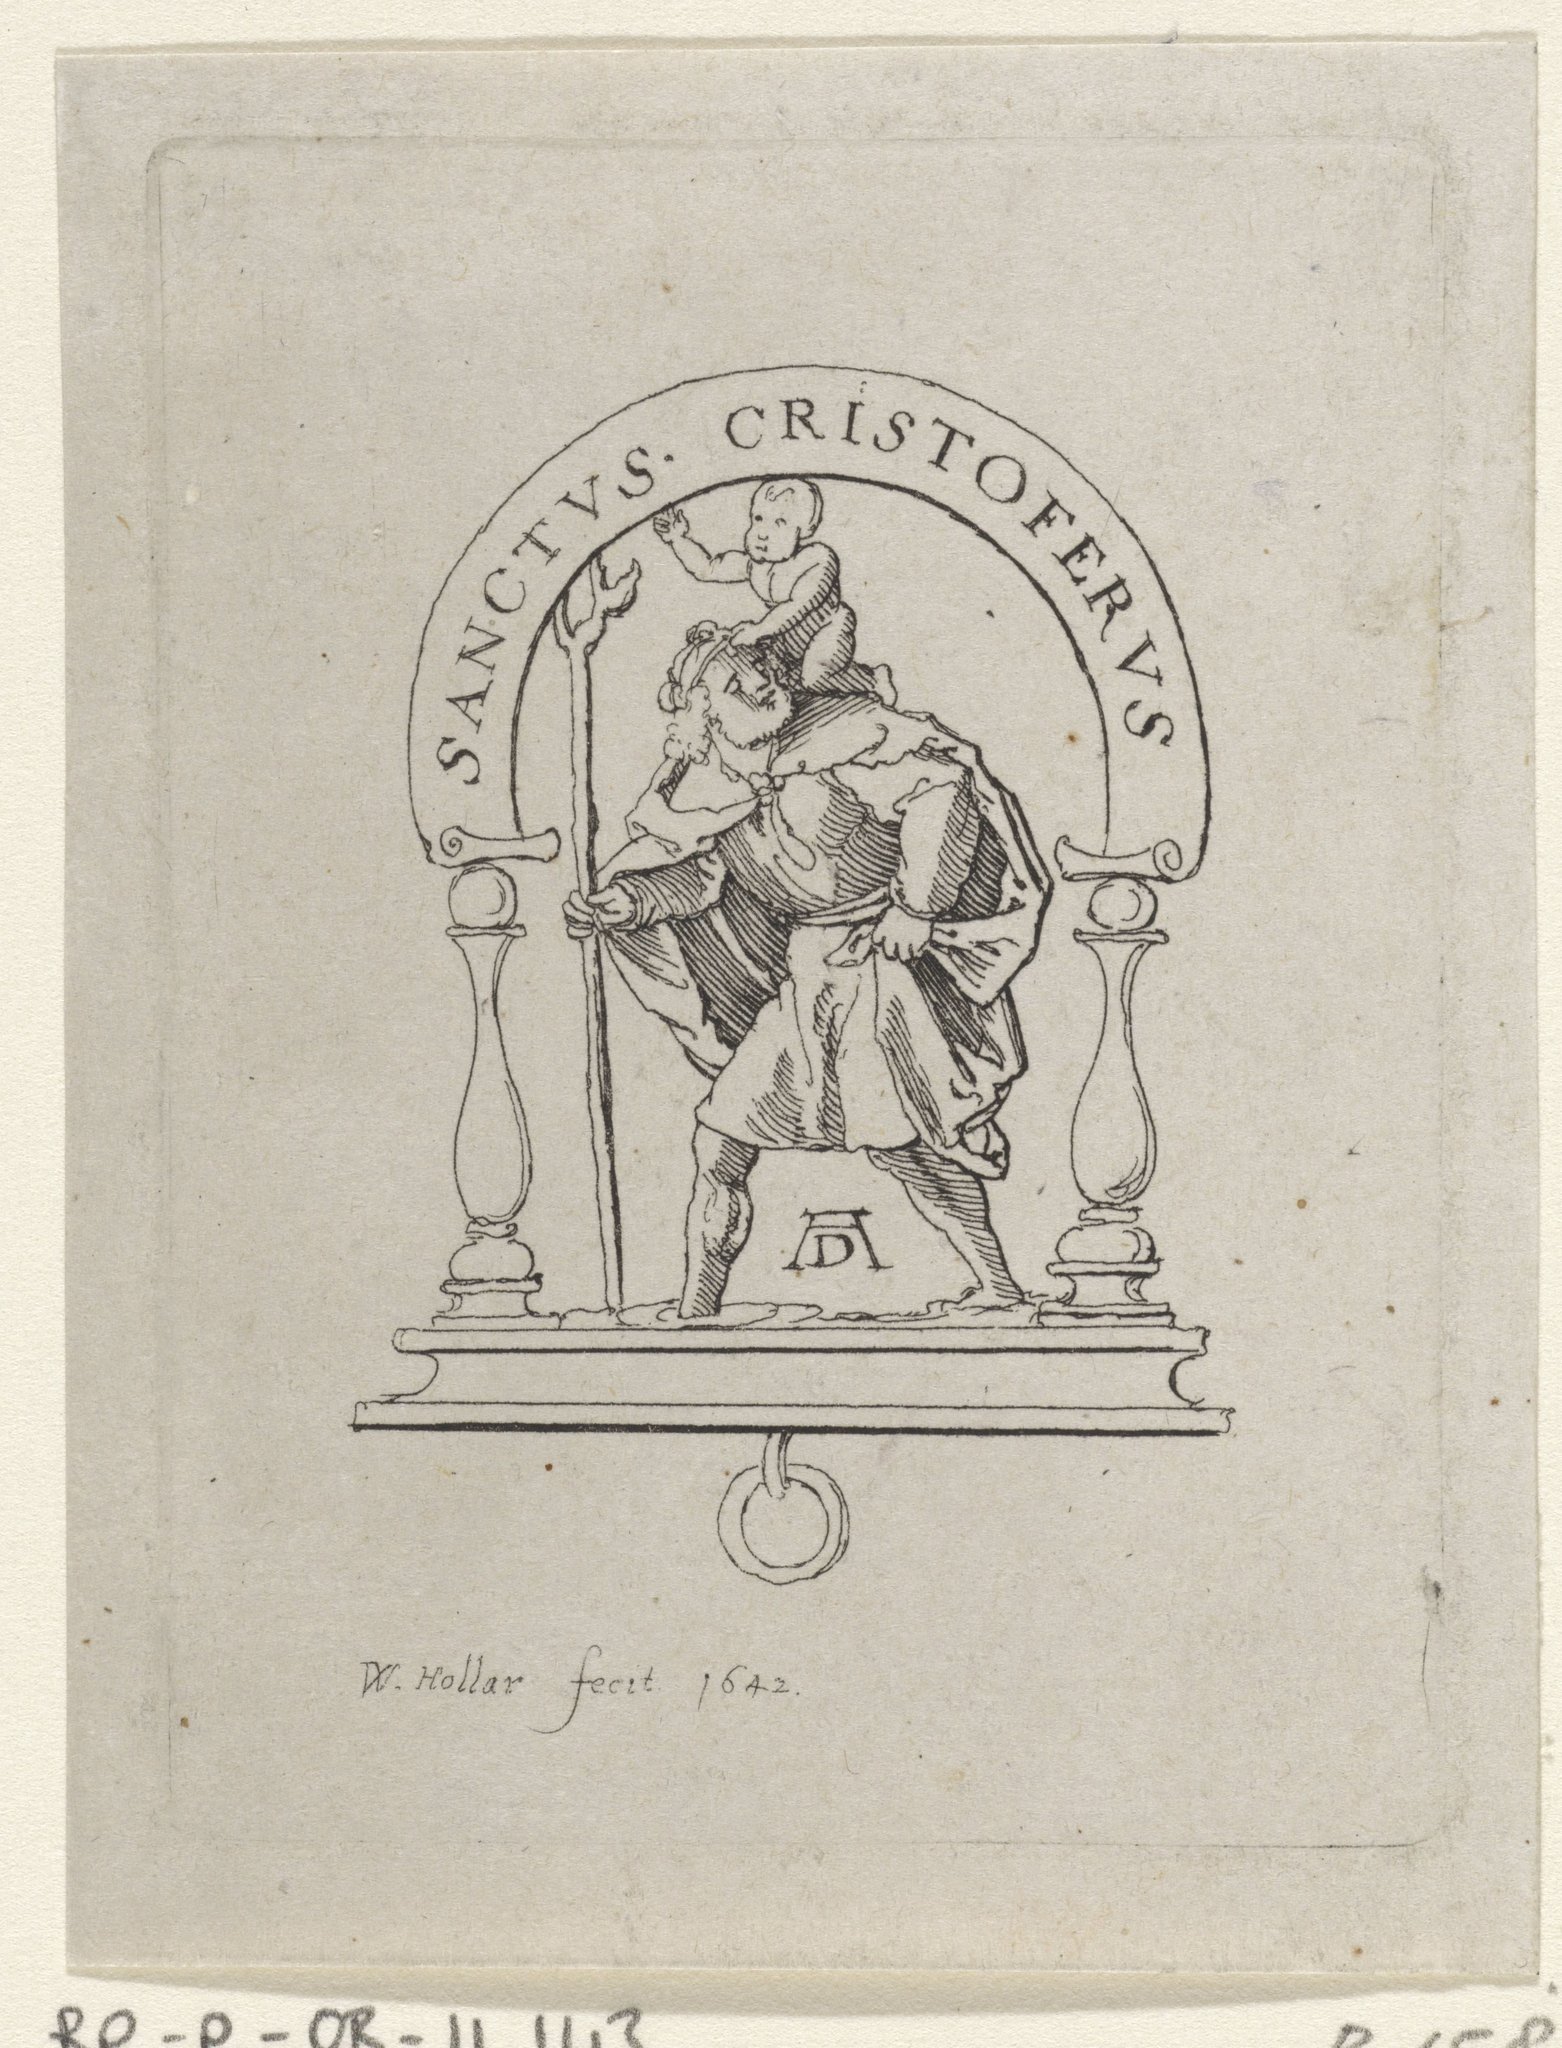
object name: print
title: Religieuze voorstellingen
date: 1642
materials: paper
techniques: etching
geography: london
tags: st. christopher, with the infant christ on his shoulders, wading through the water and carrying his staff (palm-tree); sometimes a hermit stands on the further bank beside a chapel, a lantern in his hand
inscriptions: collector's mark: Lugt 240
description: De prent maakt deel uit van een vierdelige serie prenten met religieuze voorstellingen.